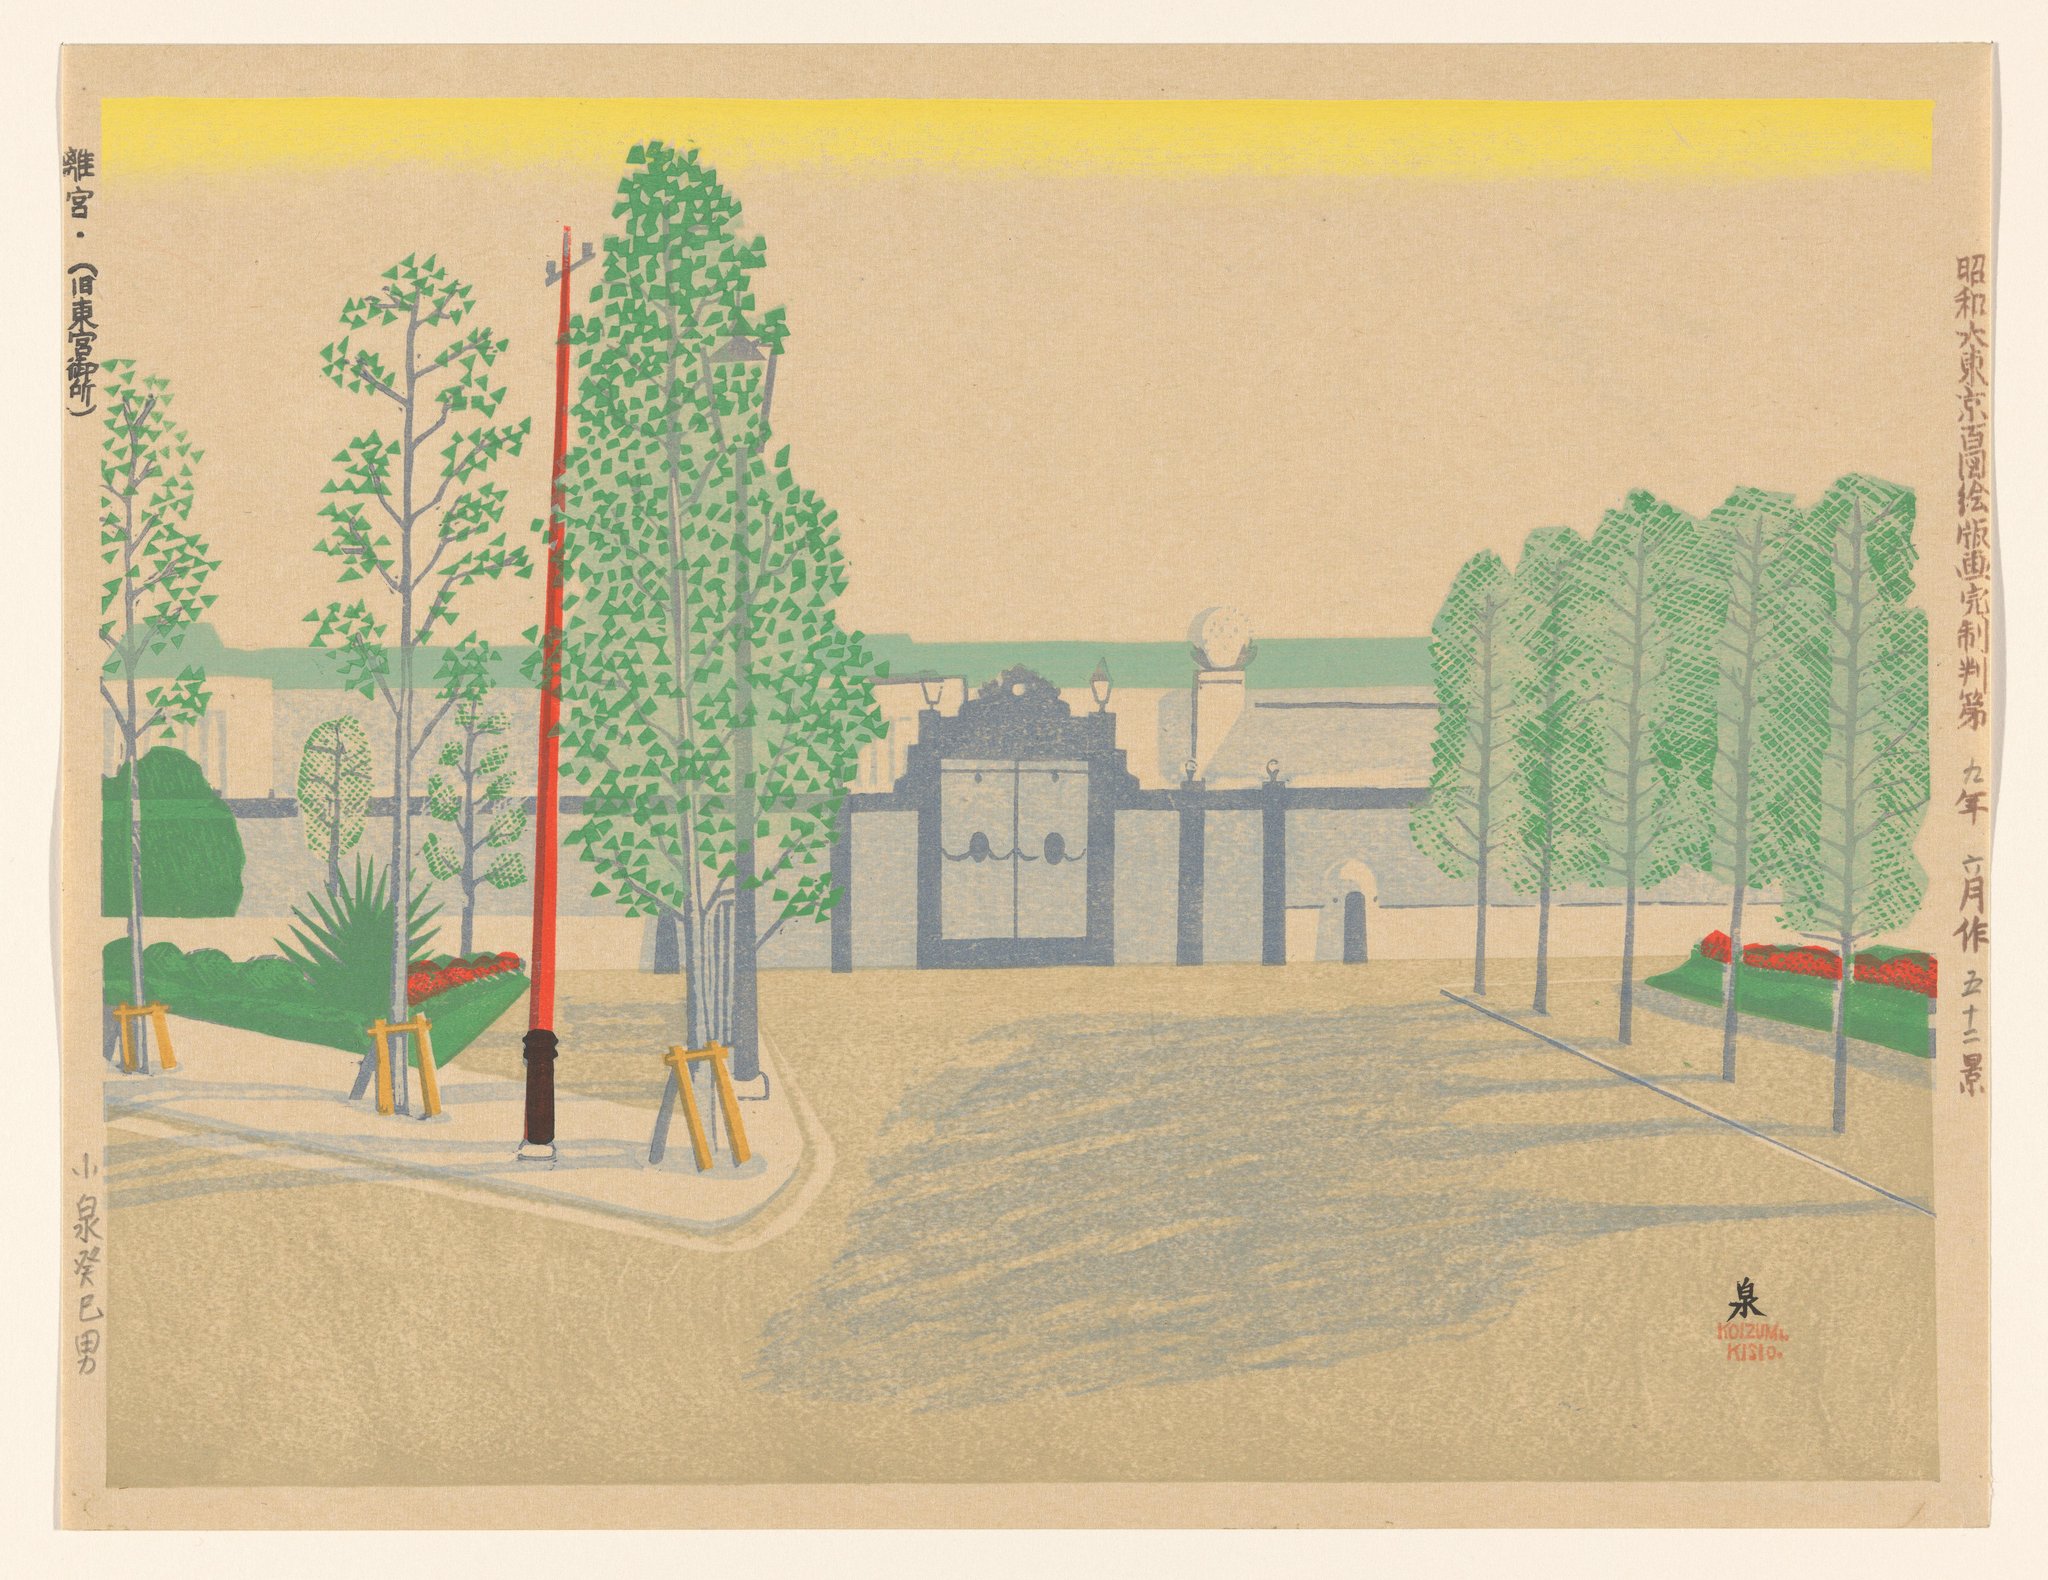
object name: print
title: Shōwa dai Tōkyō hyakuzue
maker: koizumi kishio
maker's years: 1893-1945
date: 1906-1934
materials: paper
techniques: woodcut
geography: japan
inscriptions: signature: ‘小泉癸巳男畫’, signature: ‘Koizumi Kisio.’, signature: ‘泉’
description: Een stille scène van de poort van het paleis bij Akasaka, de voormalige residentie van de kroonprins. In september 1928 begon Koizumi Kishio aan zijn ambitieuze plan om honderd landschapsprenten met scènes in Tokyo volledig zelf te ontwerpen, hiervan zelf de drukblokken te snijden en zelf de prenten te drukken. De aanleiding voor het project was grote verandering die Tokyo onderging door de verwoestende Grote Kantō-aardbeving van 1923 en de wederopbouw die daarop volgde. Kishio maakt een bewuste verwijzing naar de bekende serie ‘Honderd beroemde gezichten op Edo’ door Utagawa Hiroshige (1797–1858), met prenten van locaties in Edo—de oude benaming voor Tokyo. Kishio toont overwegend moderne gebouwen, instituten en mensen die de tijdsgeest van de jaren 1920 en 1930 weerspiegelen. Sommige prenten onthullen daarentegen een nostalgische blik op overblijfselen uit het oude Edo. Kishio verkocht de prenten aan de hand van een abonnement met een limiet van vijftig leden, die elke maand een of twee prenten zouden ontvangen. Het project begon met negen abonnementen, maar al na de tweede maand werden meerdere daarvan opgezegd en slechts vier mecenassen bleven lid tot en met de voltooiing van de serie. Hij bracht het honderdste ontwerp uit in 1937. Zijn leermeester Ishii Hakutei schreef een inleiding in 1938 die Kishio verwerkte tot een prent en toevoegde aan de set. Tussen 1939 en 1940 maakte hij nog eens negen extra ontwerpen. Met acht van deze ontwerpen verving hij oudere nummers uit de serie, mogelijk omdat hij niet tevreden was met de composities. Uiteindelijk lukte het Kishio om tien complete sets te verkopen aan de shin hanga-uitgever Watanabe Shōzaburō en liet hiervoor speciale houten dozen maken. Deze prent behoort tot een van die tien sets.